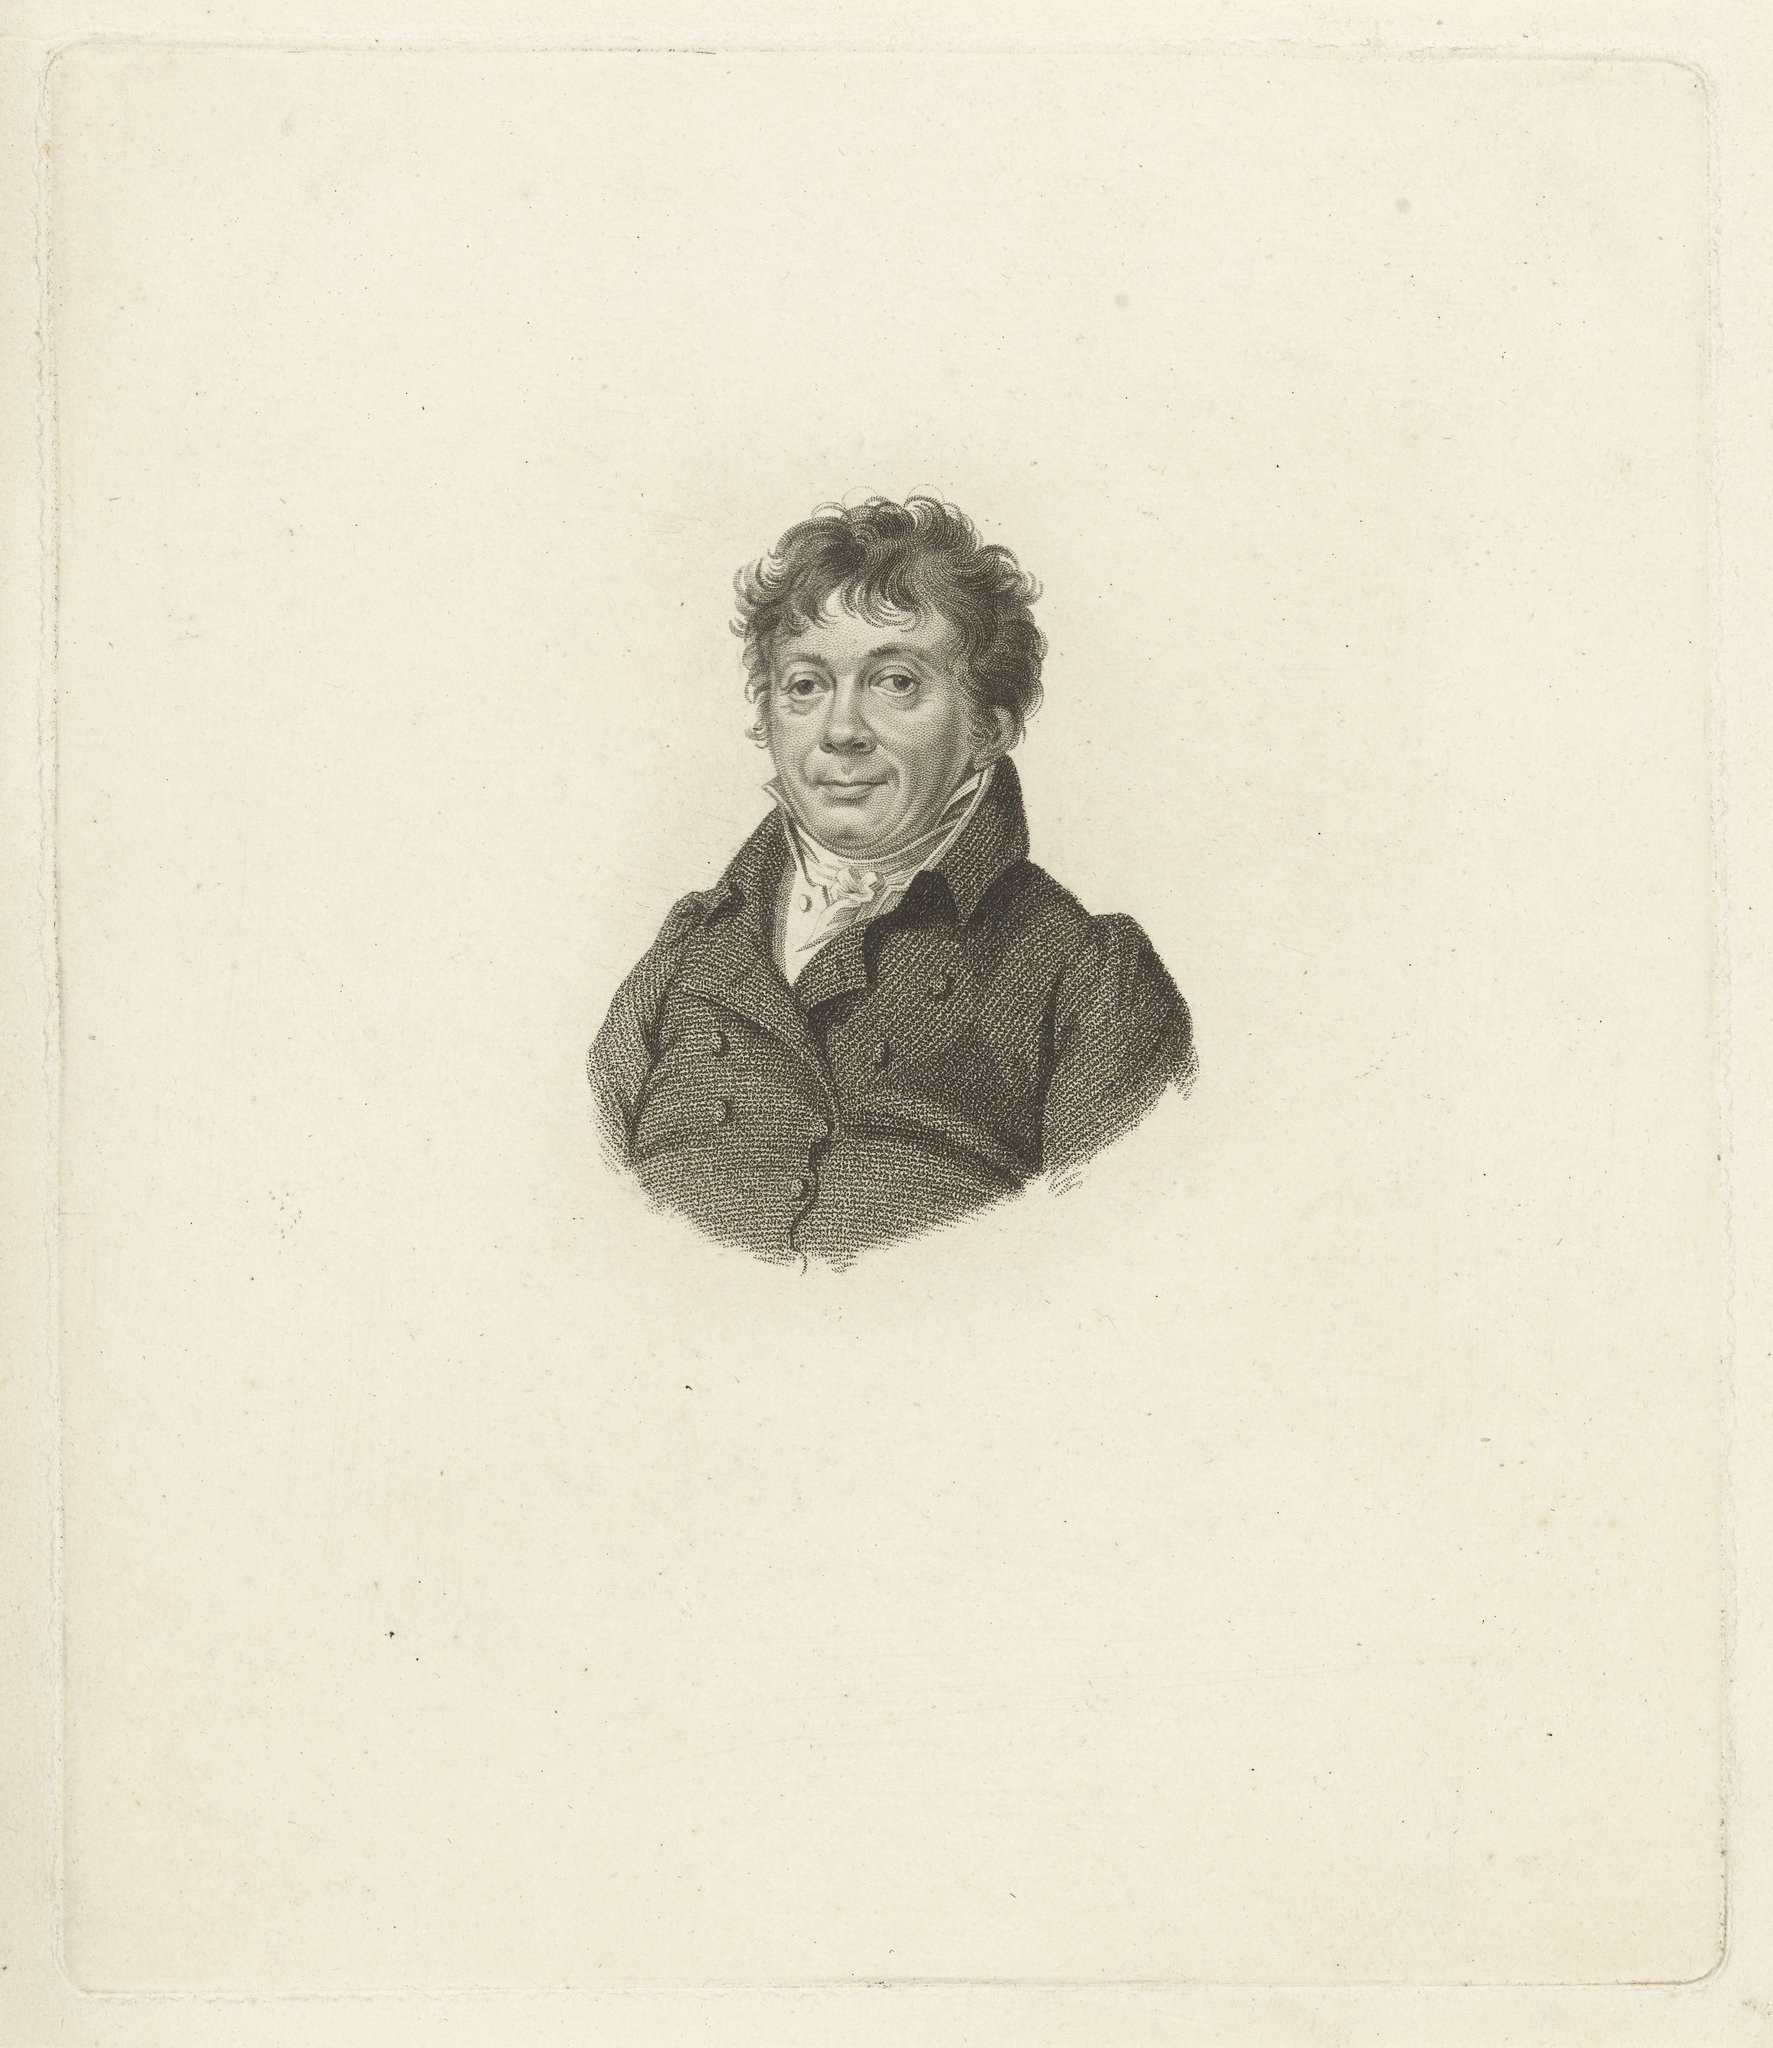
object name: print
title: Portret van George Nicolas Landré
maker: jan willem caspari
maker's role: print maker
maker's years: 1779-1822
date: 1789-1822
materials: paper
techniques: etching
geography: amsterdam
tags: cassel, directeur, george nicolas landré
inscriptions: collector's mark: Lugt 2228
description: Portret van George Nicolas Landré, directeur van een Amsterdamse meisjesschool. Buste naar links.